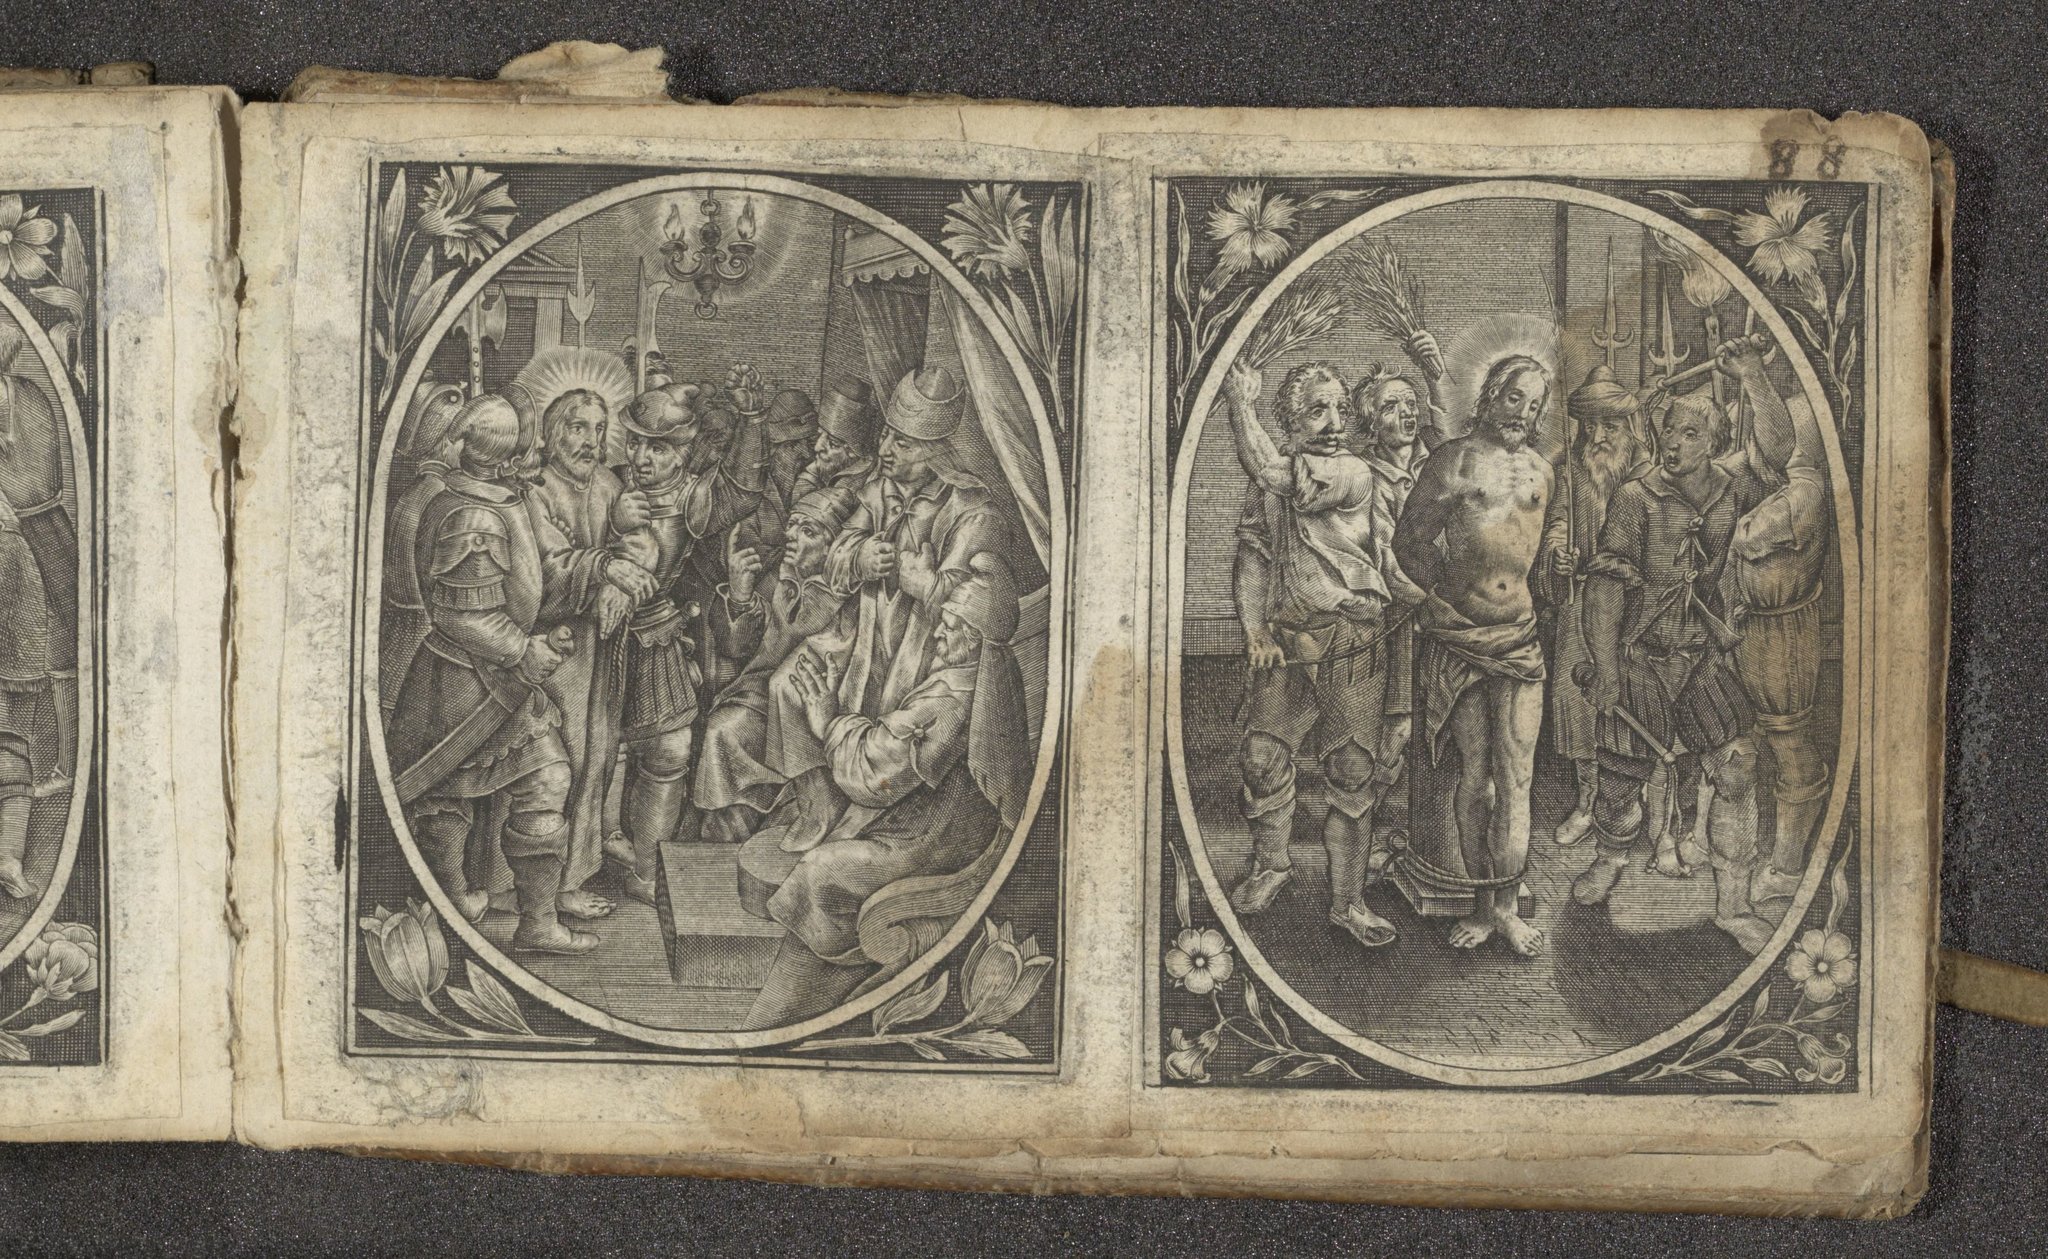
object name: album leaf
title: Passie van Christus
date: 1576-1650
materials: paper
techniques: engraving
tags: caiaphas tearing his clothes ~ trial of christ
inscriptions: inscription: ‘88’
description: Soldaten nemen de geboeide Christus mee aan de arm. Hij wordt berecht door Kajafas. De hogepriester scheurt zijn gewaad en beschuldigt Christus van godslastering. Ovaal binnen een rechthoekig kader, in elke hoek een bloem. De prent maakt deel uit van een album.